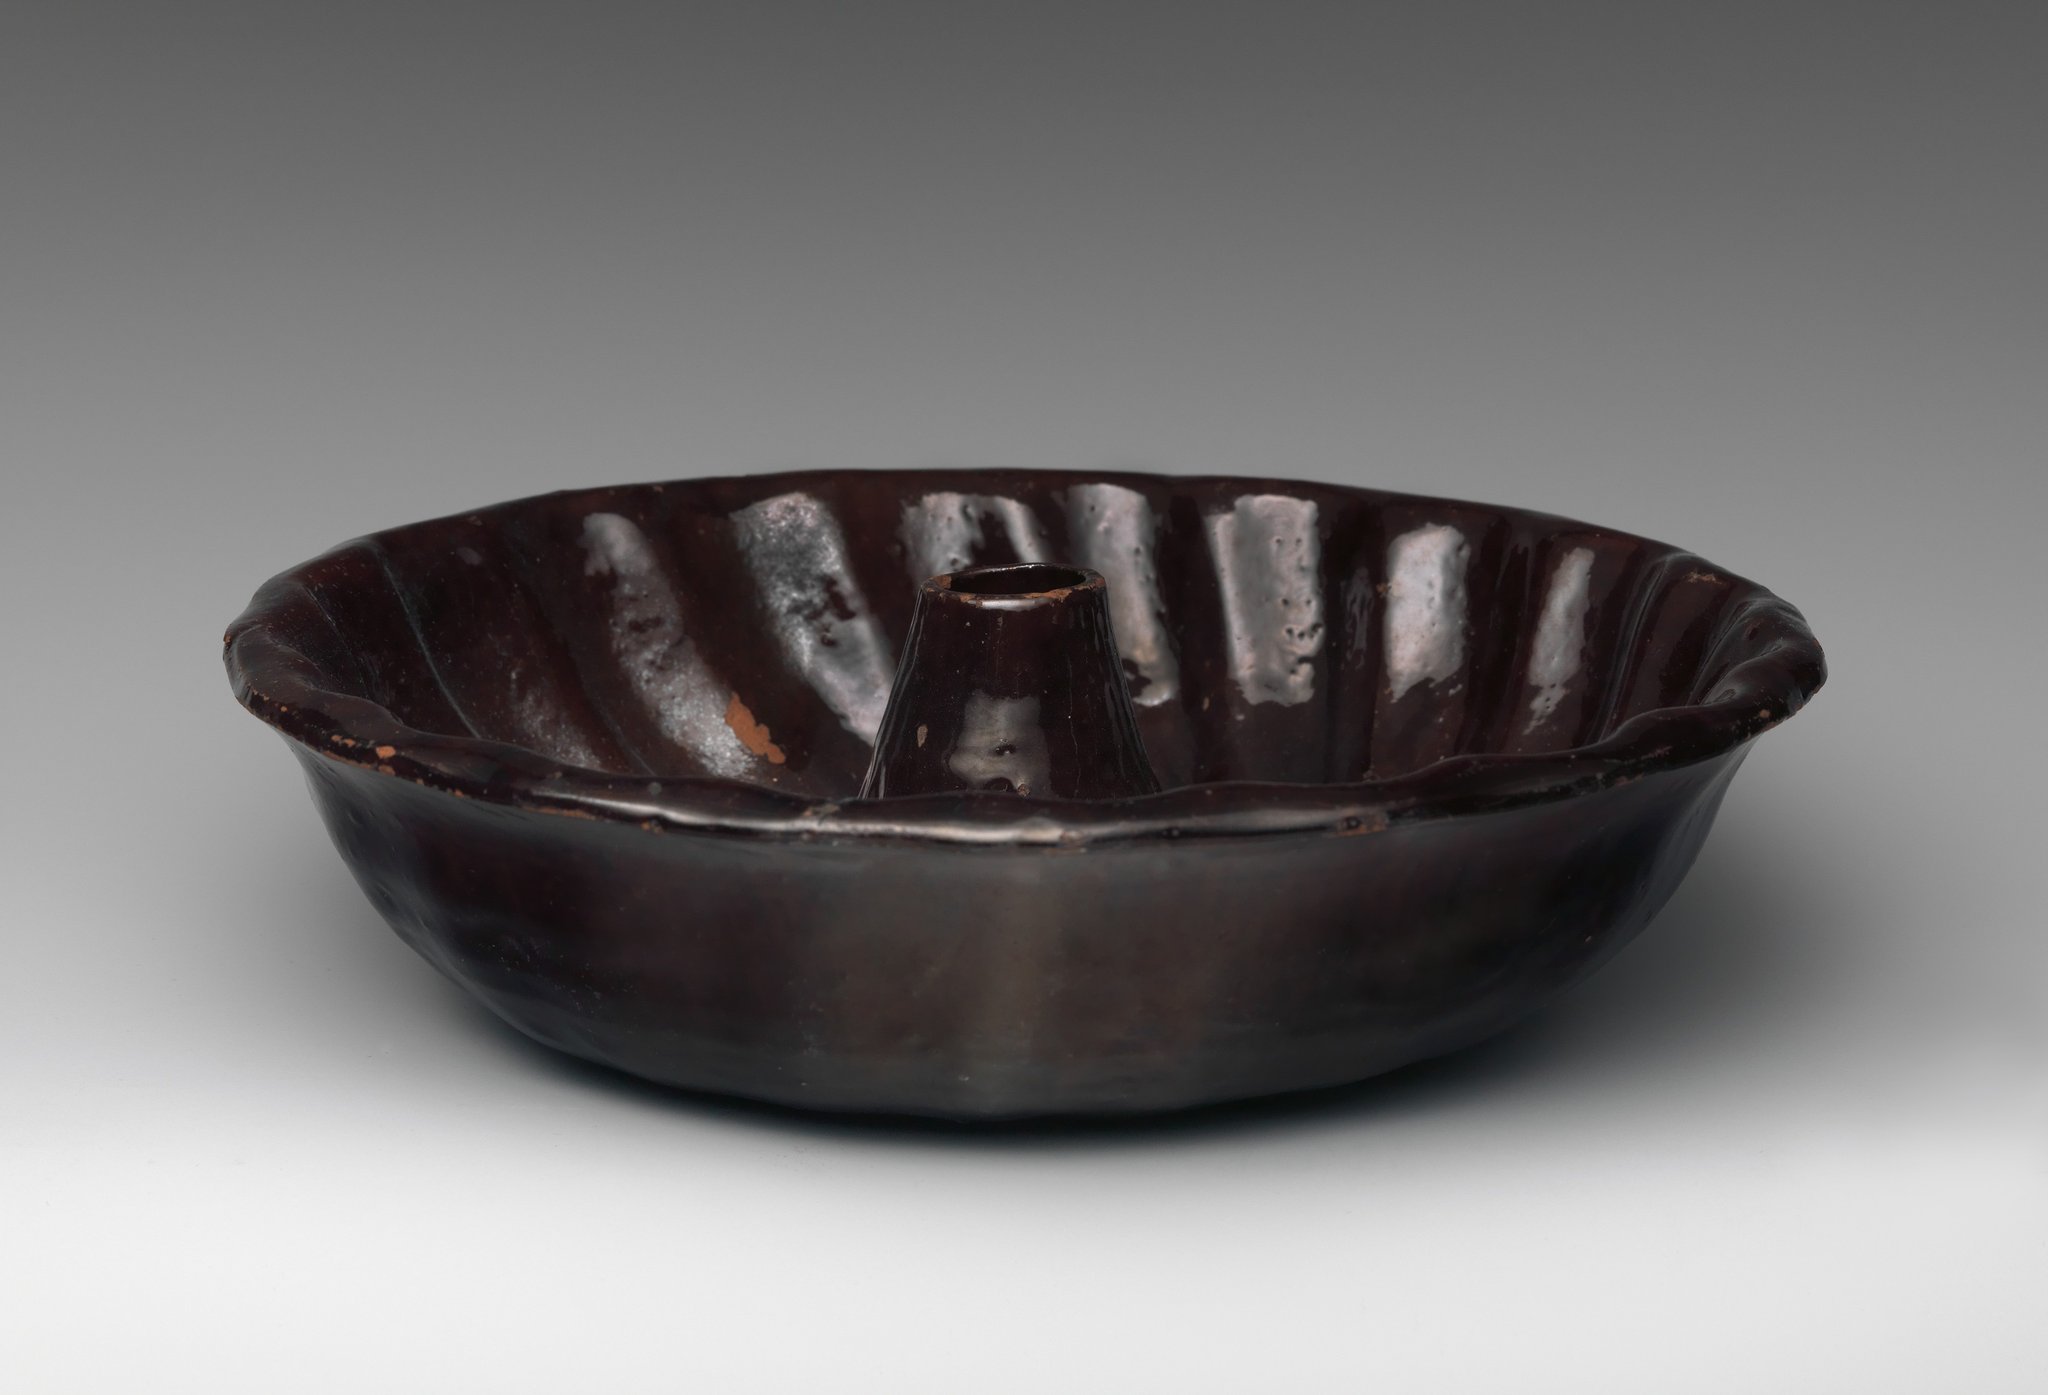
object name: dish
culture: american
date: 1800-1830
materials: earthenware